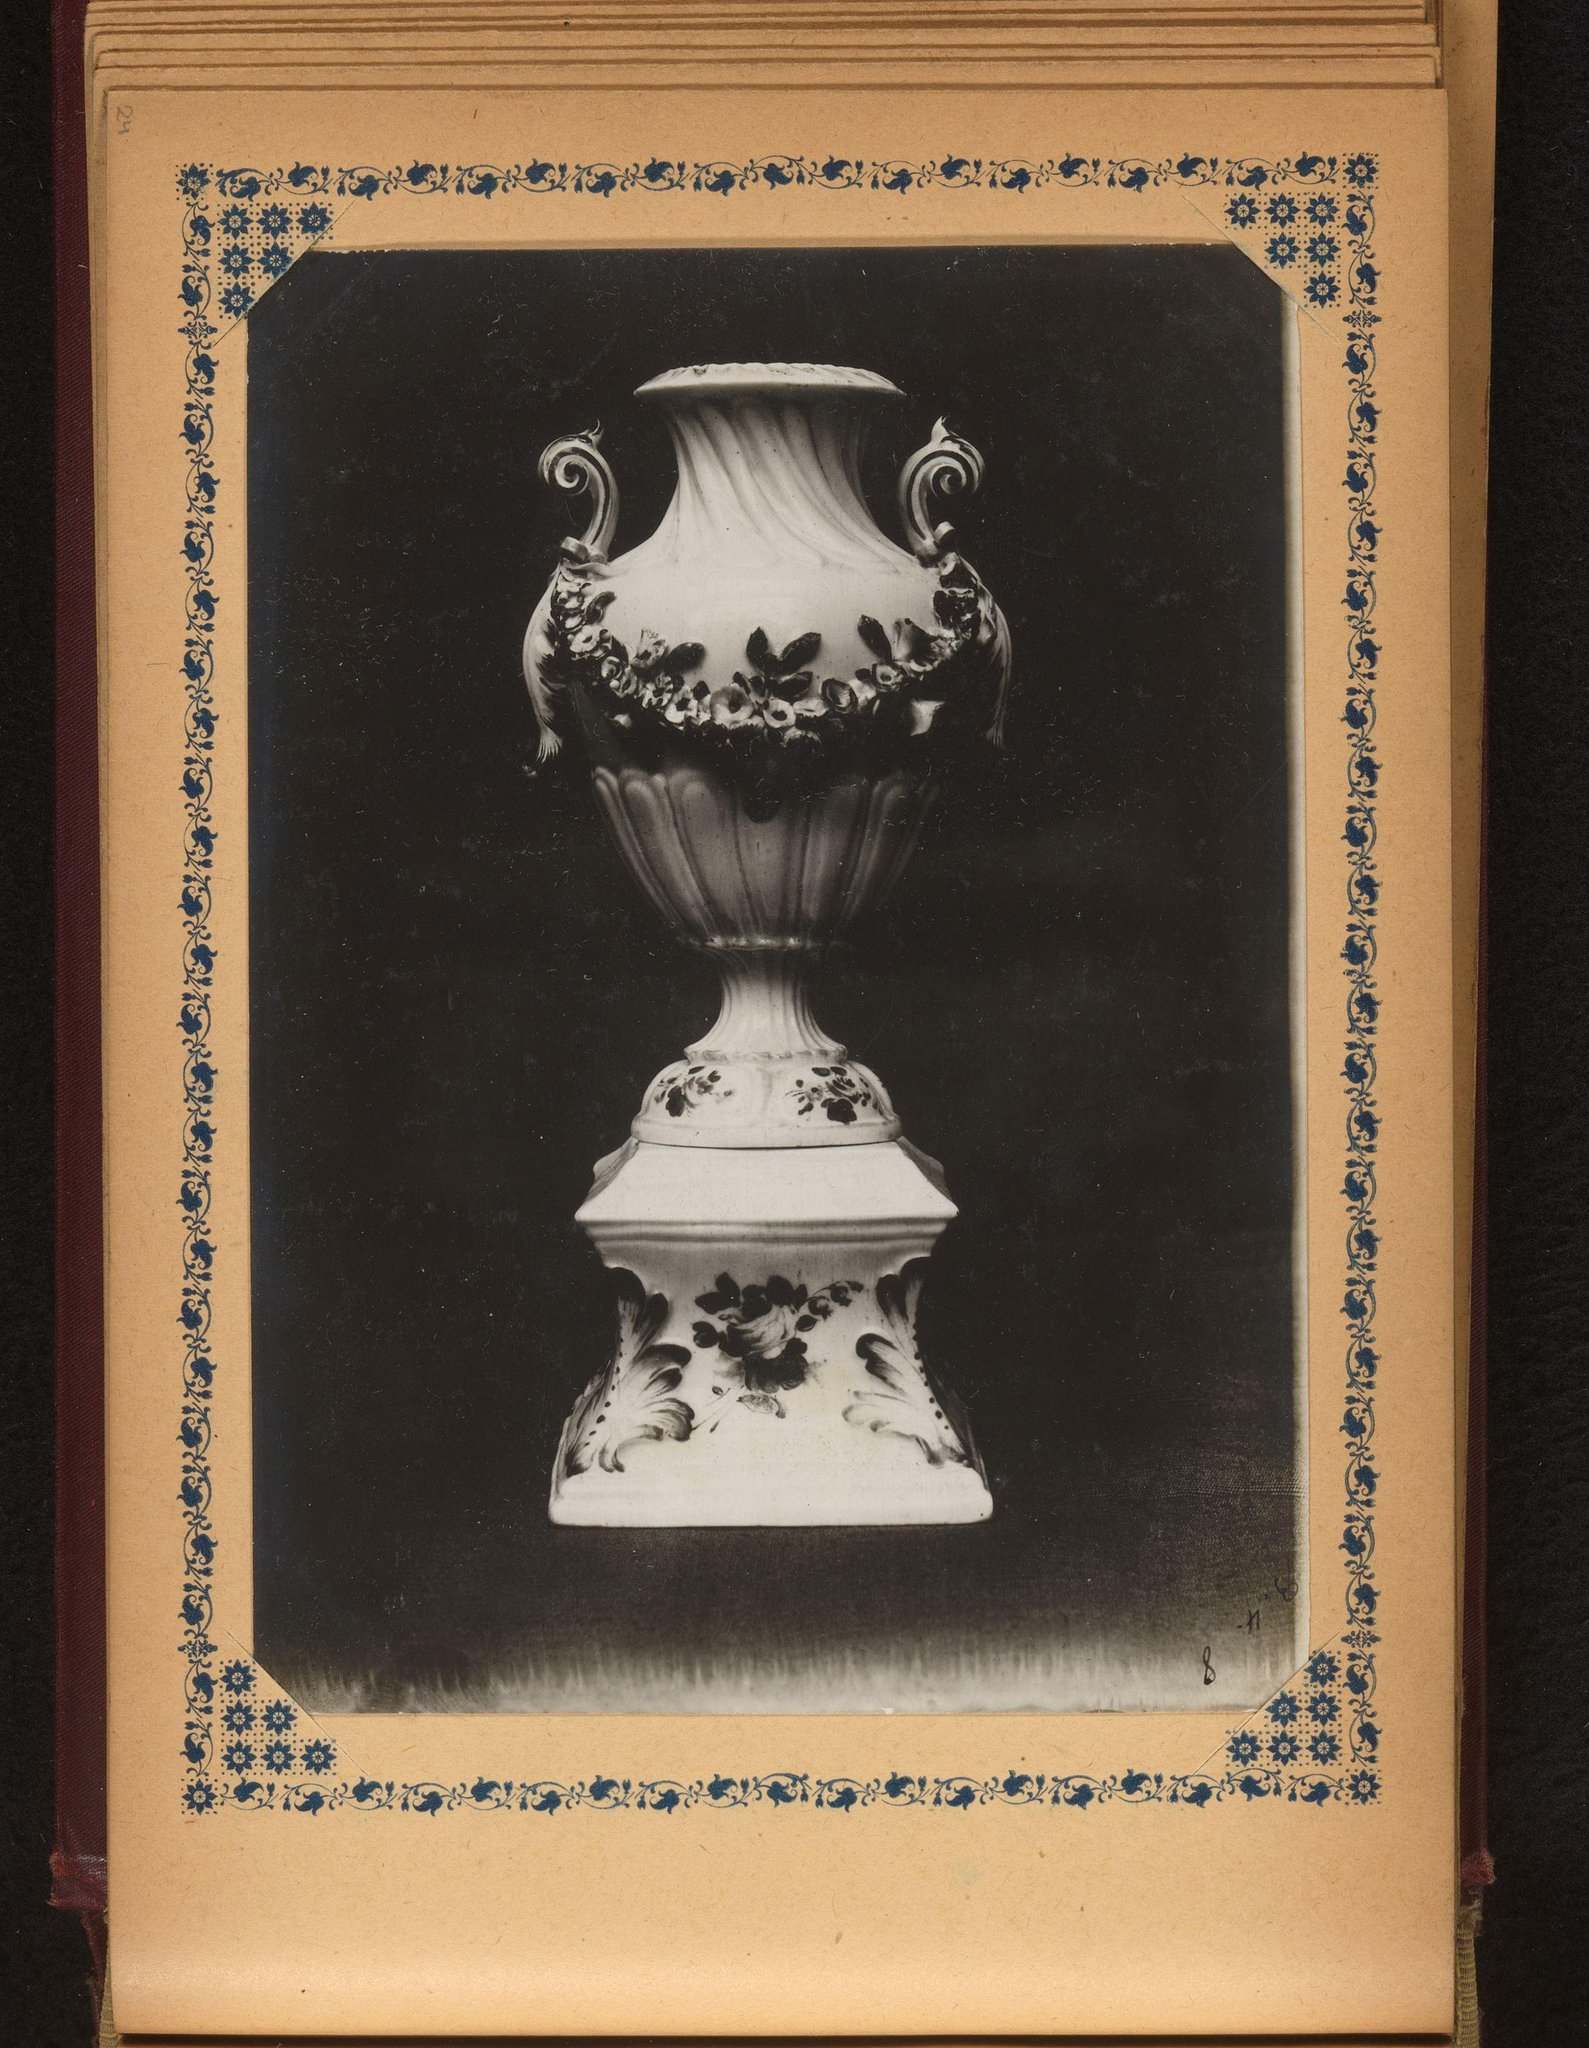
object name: photograph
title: Vaas beschilderd met bloemen en gedecoreerd met een guirlande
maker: Anonymous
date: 1880-1940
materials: cardboard, photographic support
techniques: gelatin silver print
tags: flowers, container of ceramics: jar, jug, pot, vase, ornament ~ festoon, garland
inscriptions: number: ‘B. 4. 8’